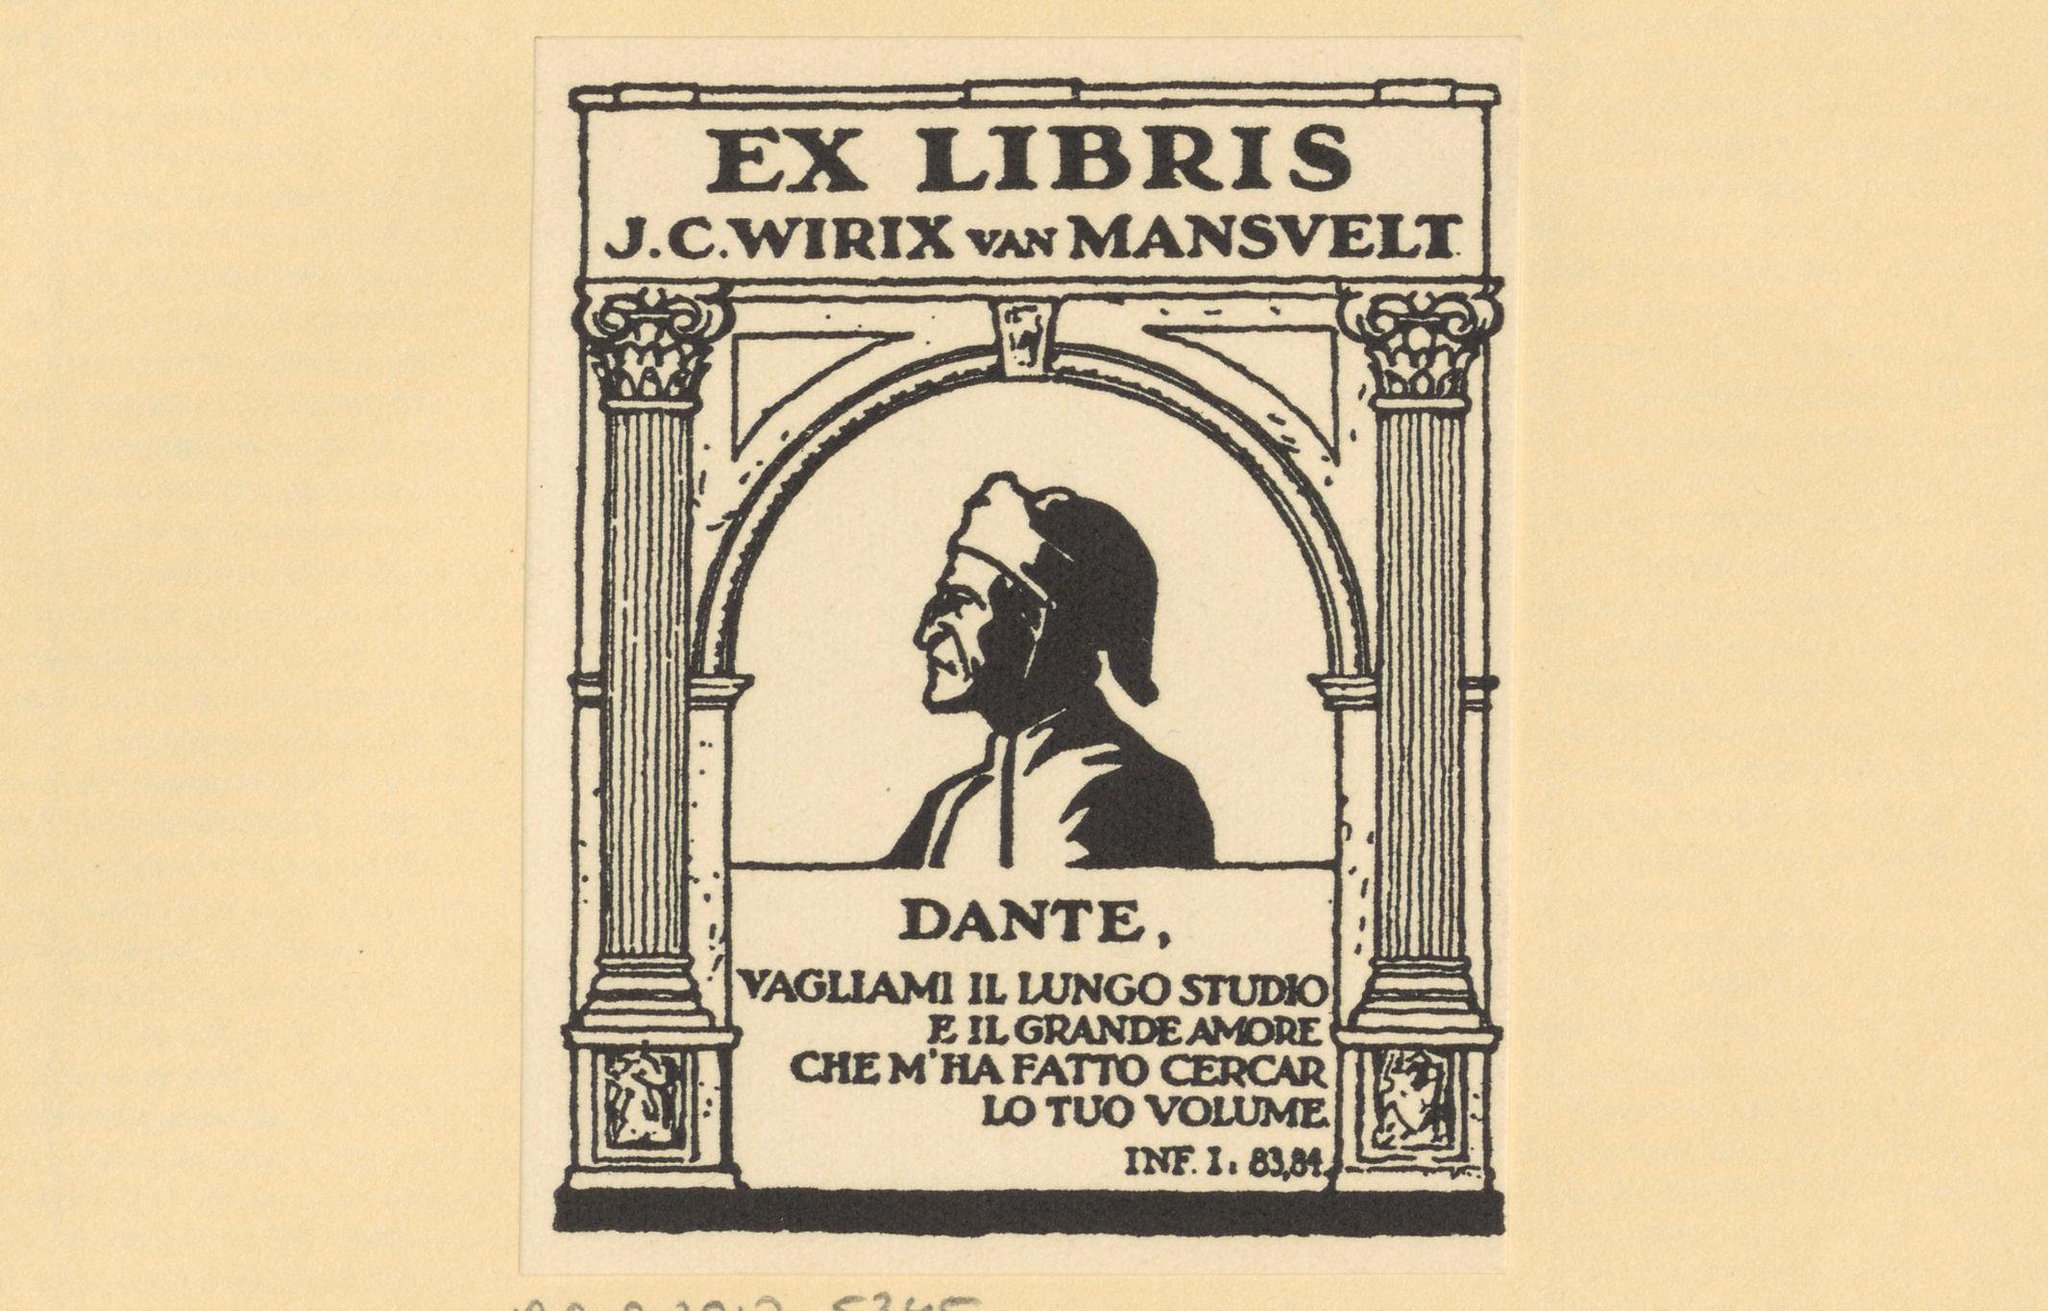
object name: bookplate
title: Ex libris van J.C. Wirix van Mansvelt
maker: Anonymous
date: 1923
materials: paper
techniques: printing block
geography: netherlands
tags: dante alighieri, column, pillar ~ architecture, portrait of a writer